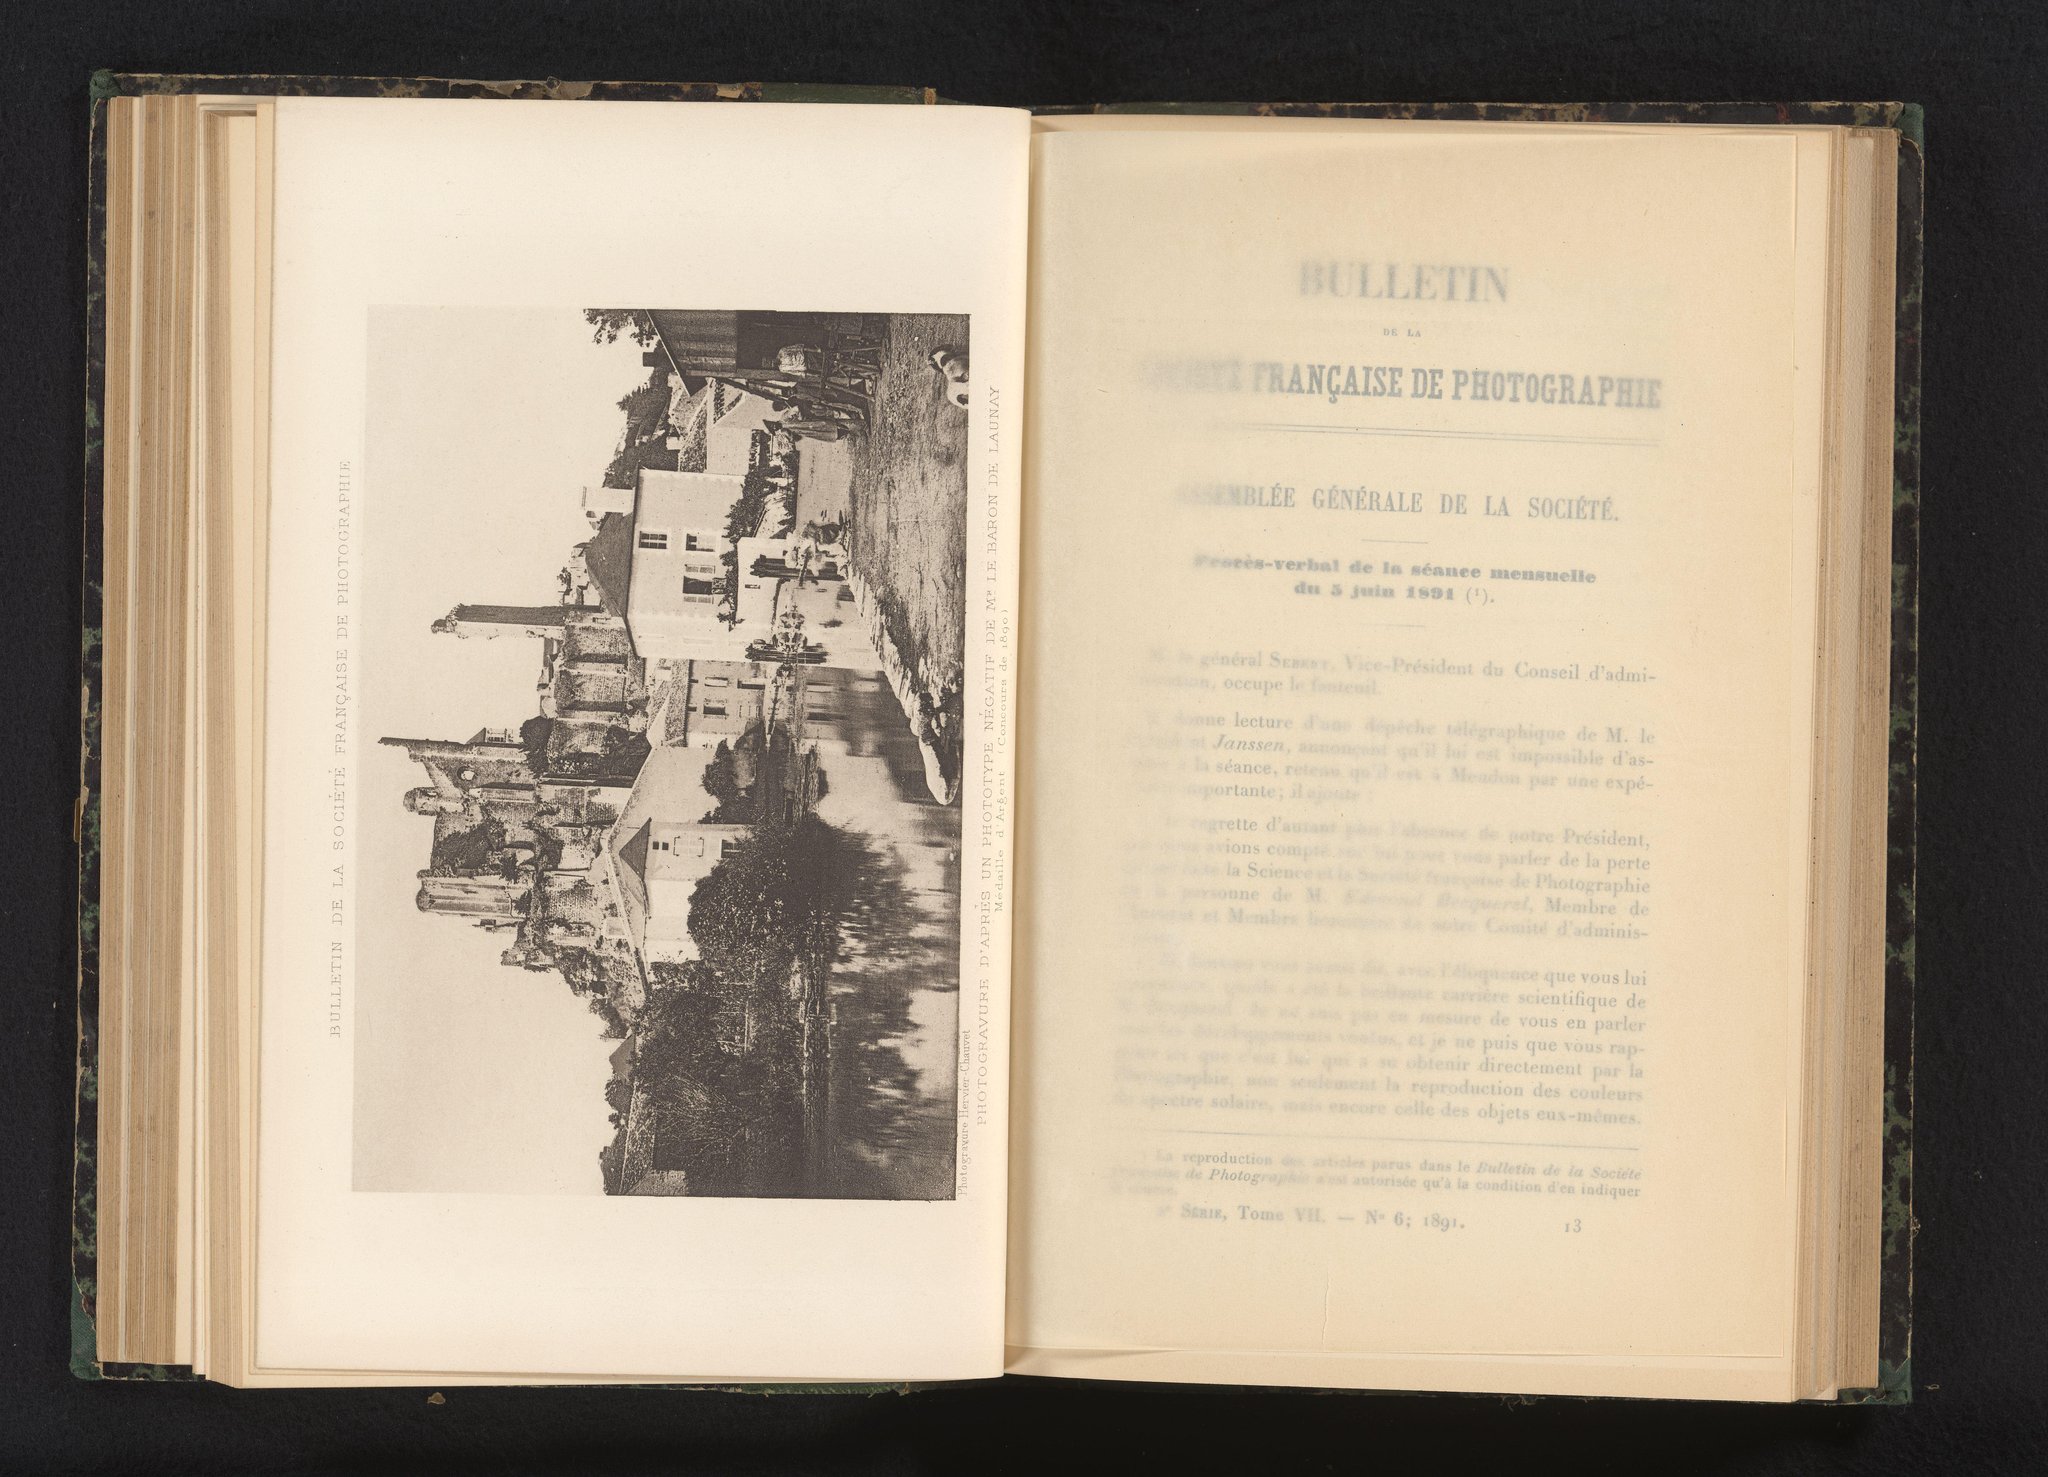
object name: photomechanical print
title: Gezicht op een dorp aan een rivier met een kasteelruïne, waarschijnlijk in Frankrijk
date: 1885-1890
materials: paper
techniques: photoaquatint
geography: france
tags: river, village, landscape with ruins, ruin of a dwelling, house, castle, etc., france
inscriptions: inscription: ‘Photogravure d'après un phototype négatif de Mr le baron de Launay/ Médaille d'Argent (Concours de 1890)’